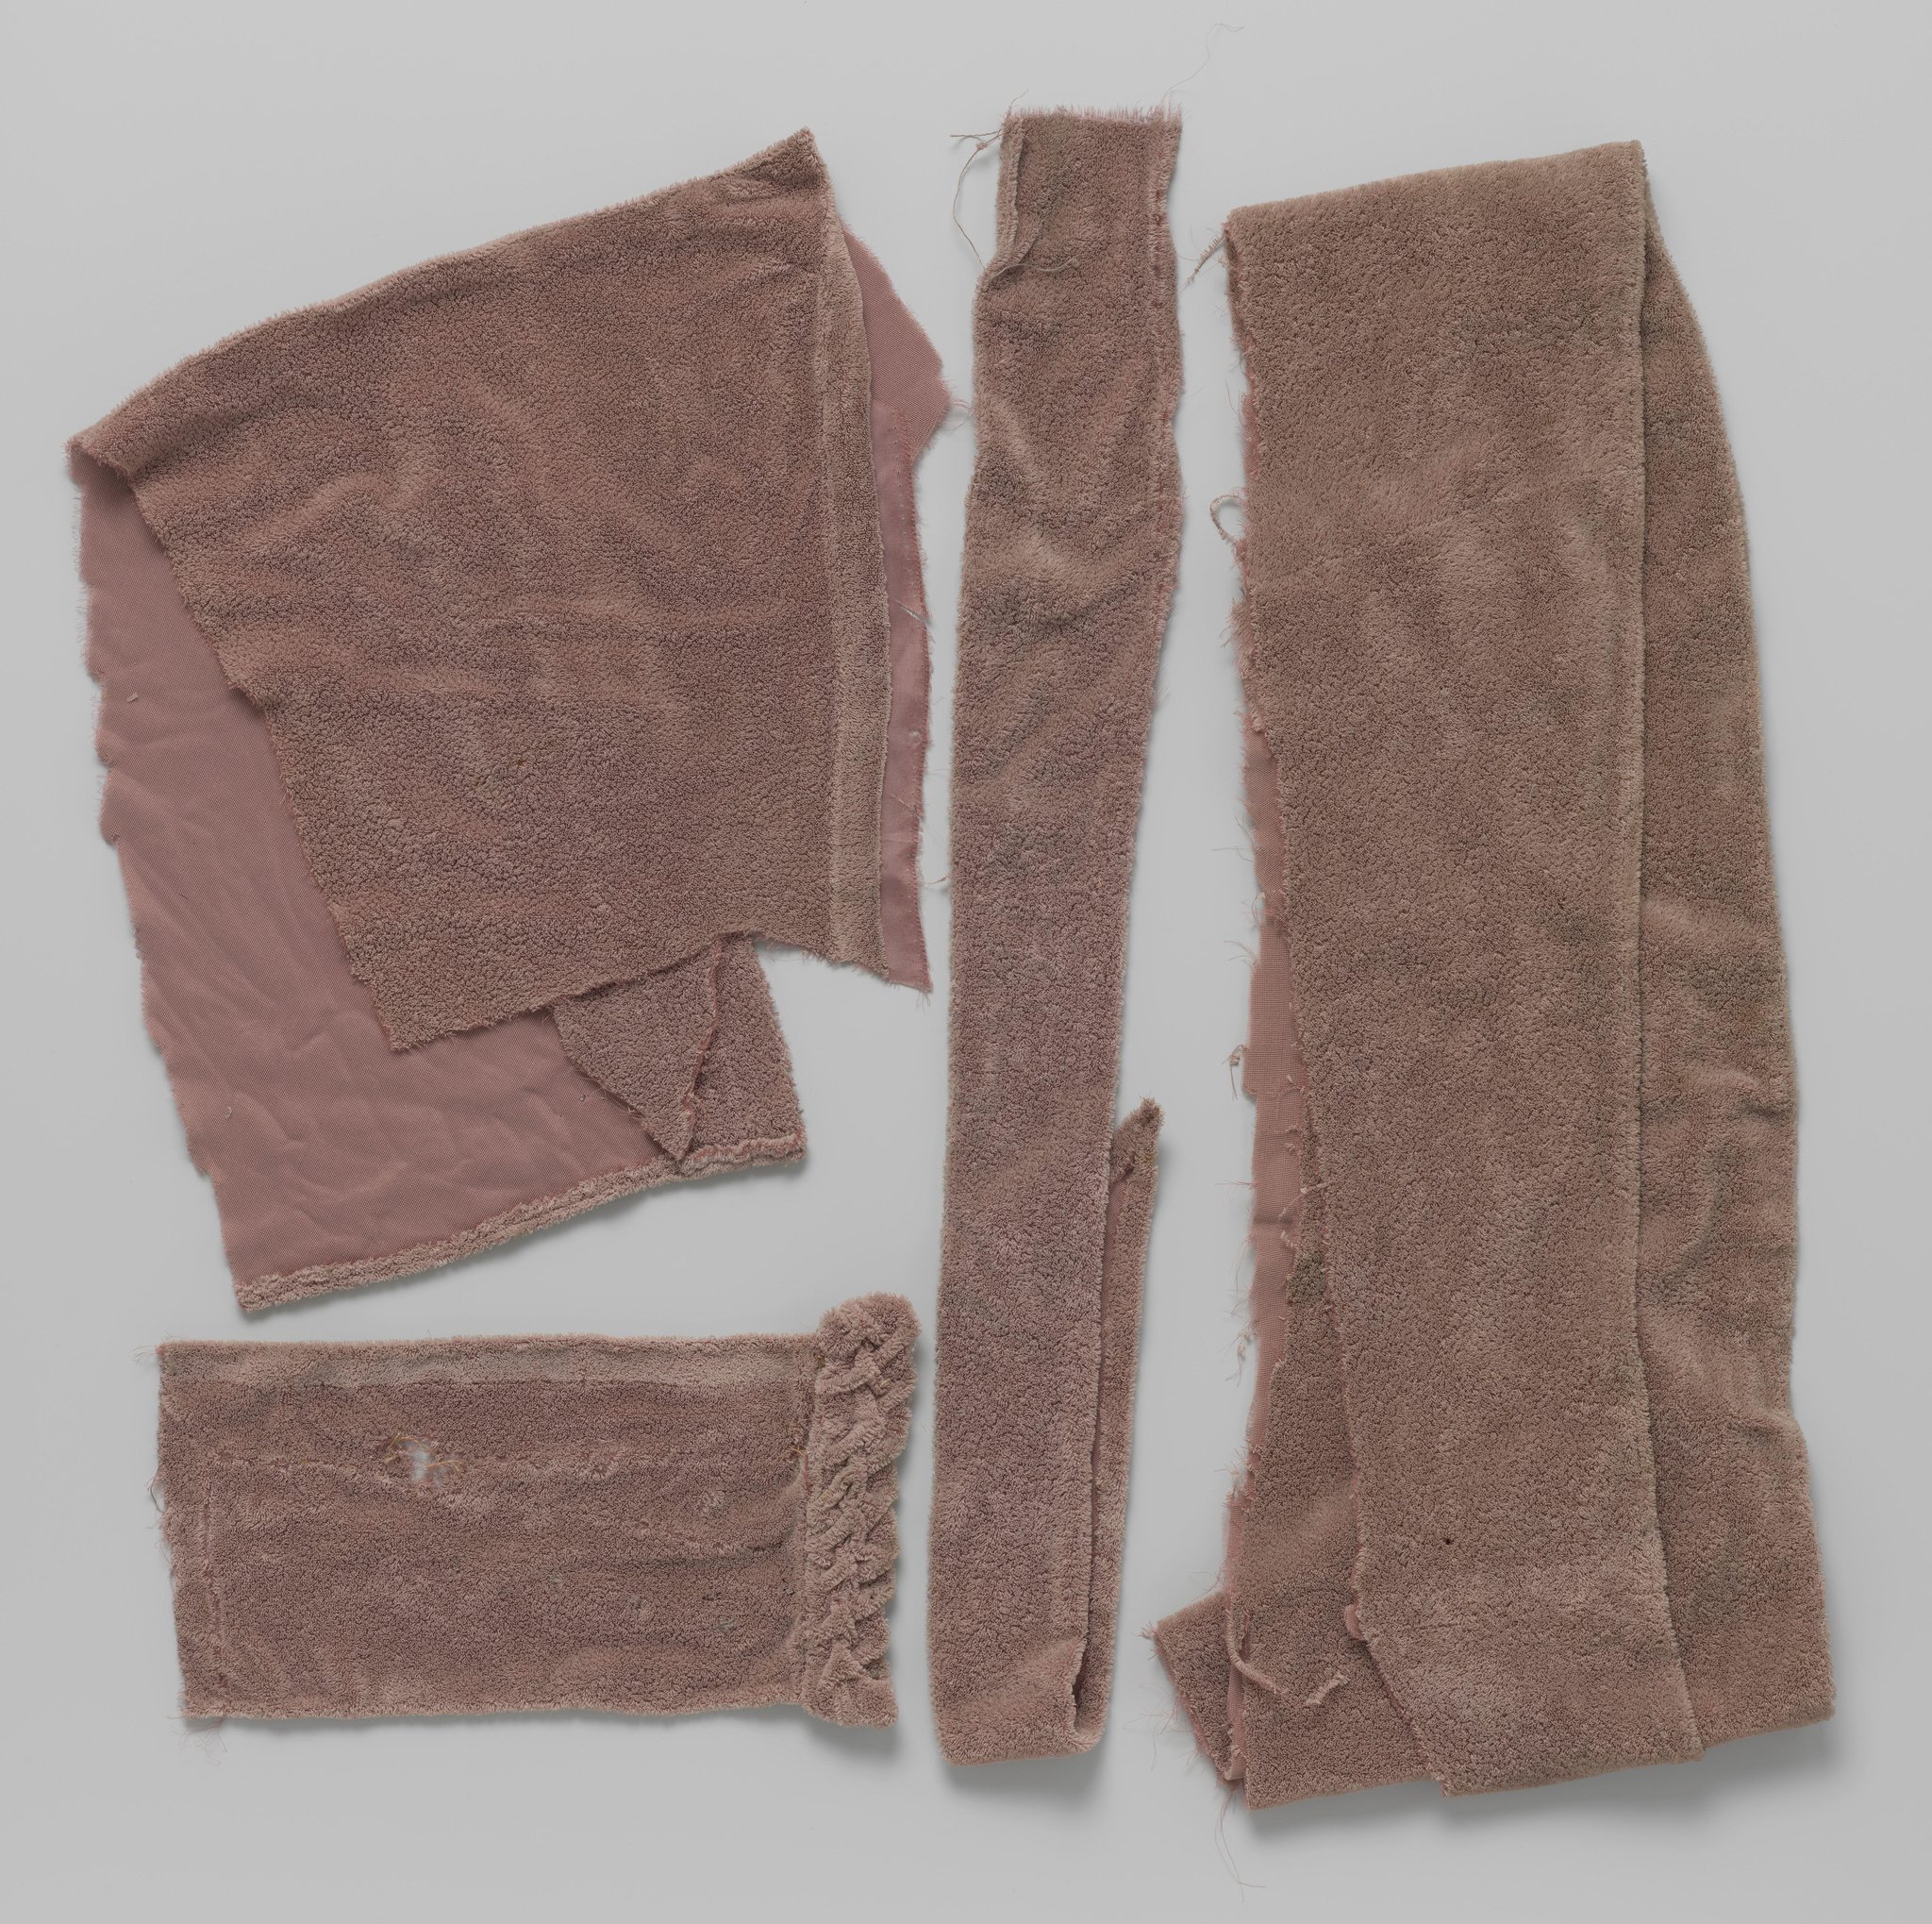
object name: main garment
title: Japon van grijze crêpe met enveloppe waarin 5 losse fragmenten van de stof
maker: mejuffrouw haag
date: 1930-1939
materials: textile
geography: netherlands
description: Japon van grijze crêpe (a) met enveloppe waarin 5 losse fragmenten van de stof (b).